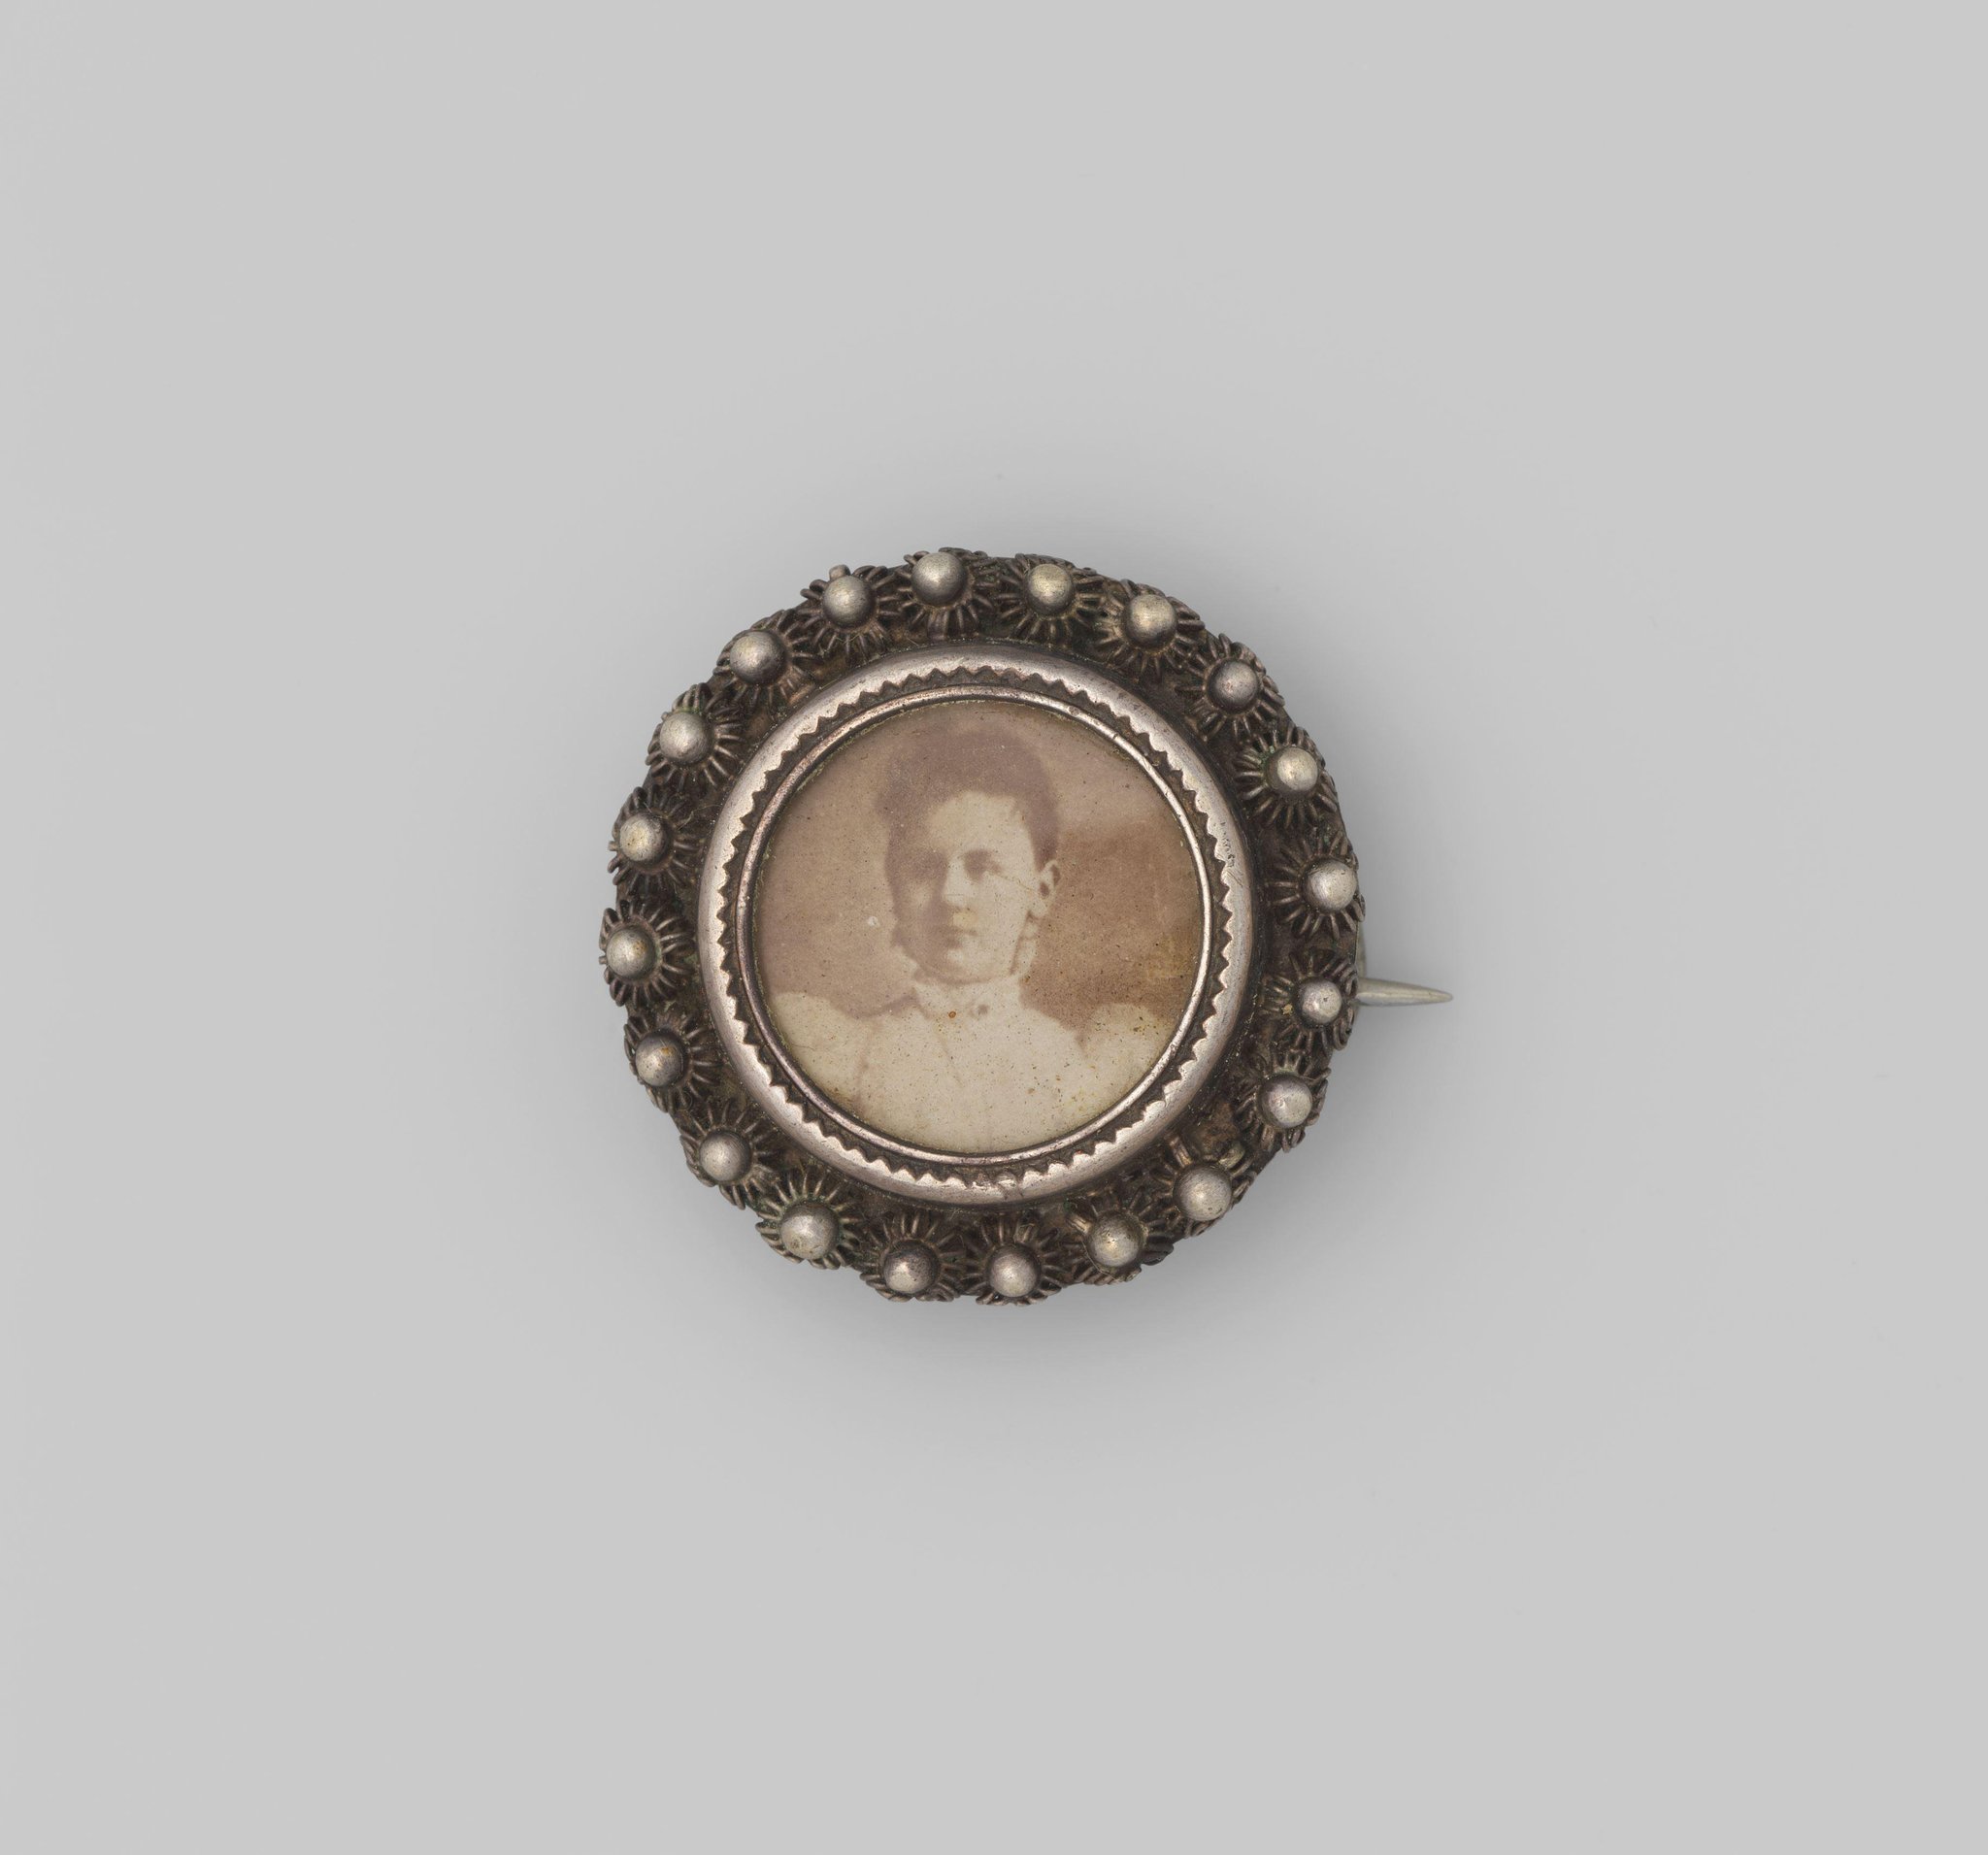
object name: photograph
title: Portret van koningin Wilhelmina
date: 1897-1900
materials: paper, silver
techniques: albumen print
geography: the hague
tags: the hague, print maker, wilhelmina of the netherlands, historical persons, queen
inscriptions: inscription: ‘gekocht juli 1970 f22-/ [...] A'dam/ [...]/ (foto Wilhelmina)’